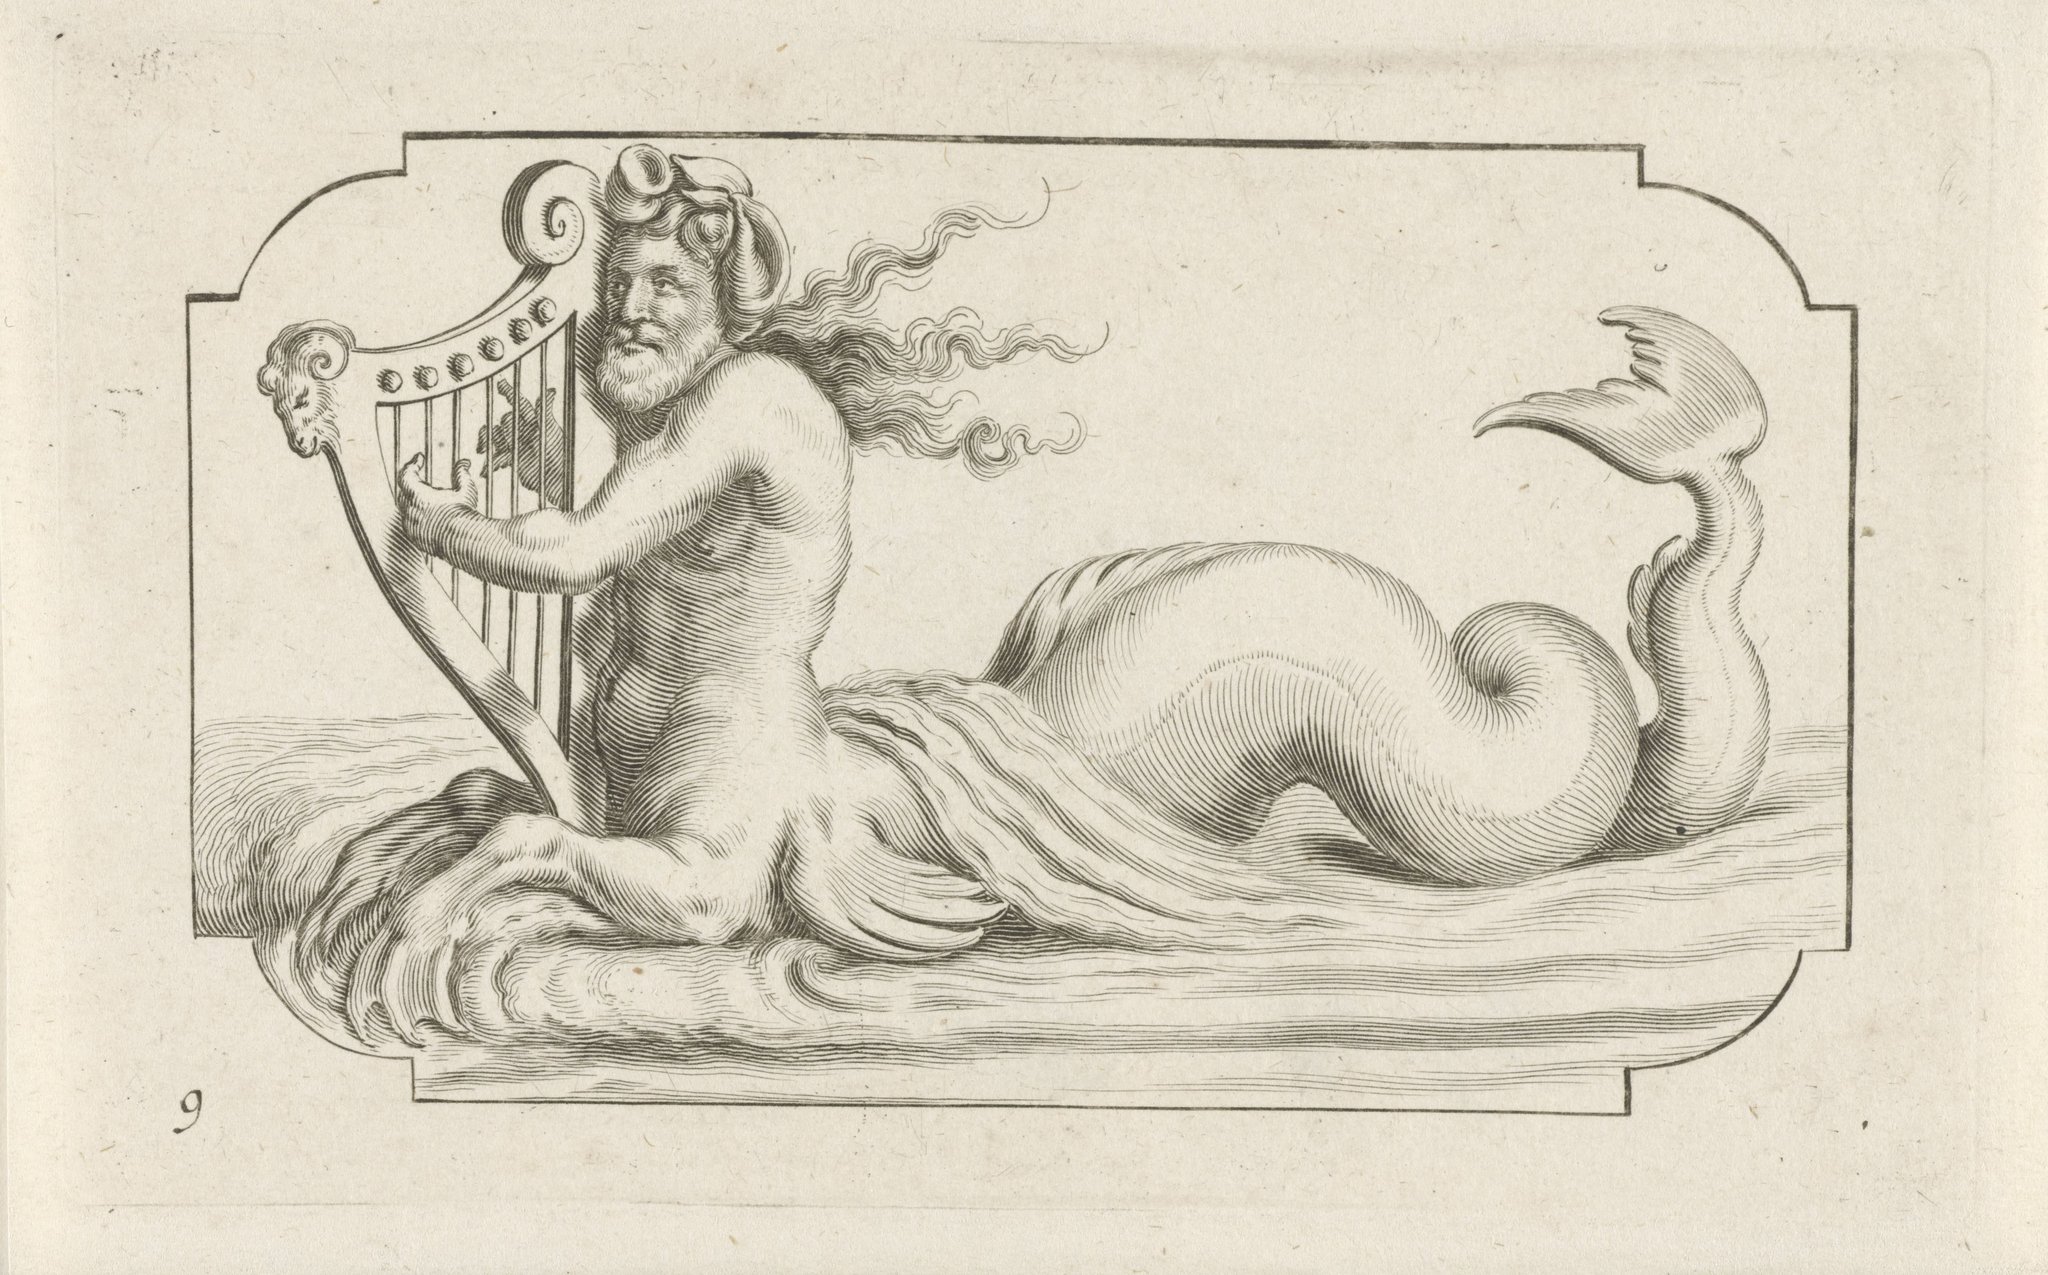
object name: print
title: Triton die op een harp speelt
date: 1656-1701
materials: paper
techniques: engraving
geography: amsterdam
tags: triton(s), harp